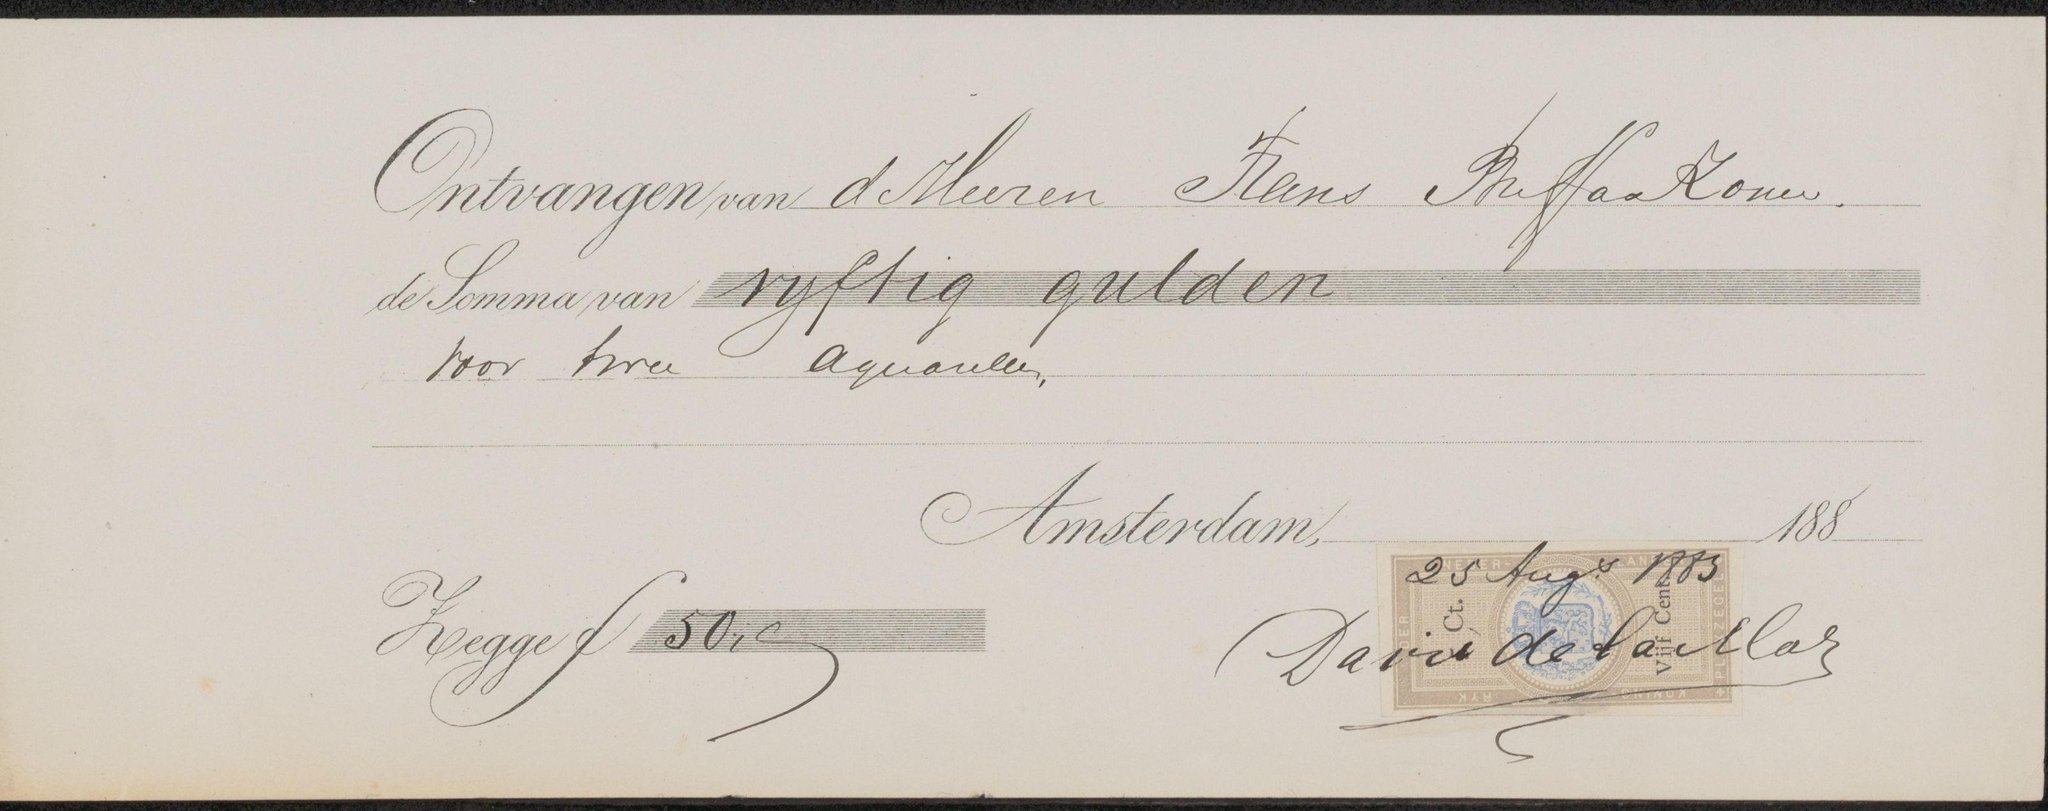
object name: ontvangstbewijs, kwitantie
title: Kwitantie voor David de la Mar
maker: david de la mar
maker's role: draughtsman, painter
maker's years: 1832-1898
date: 1883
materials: ink, paper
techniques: pen, printing, writing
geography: amsterdam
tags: drawing, money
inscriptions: collector's mark: Lugt 2233